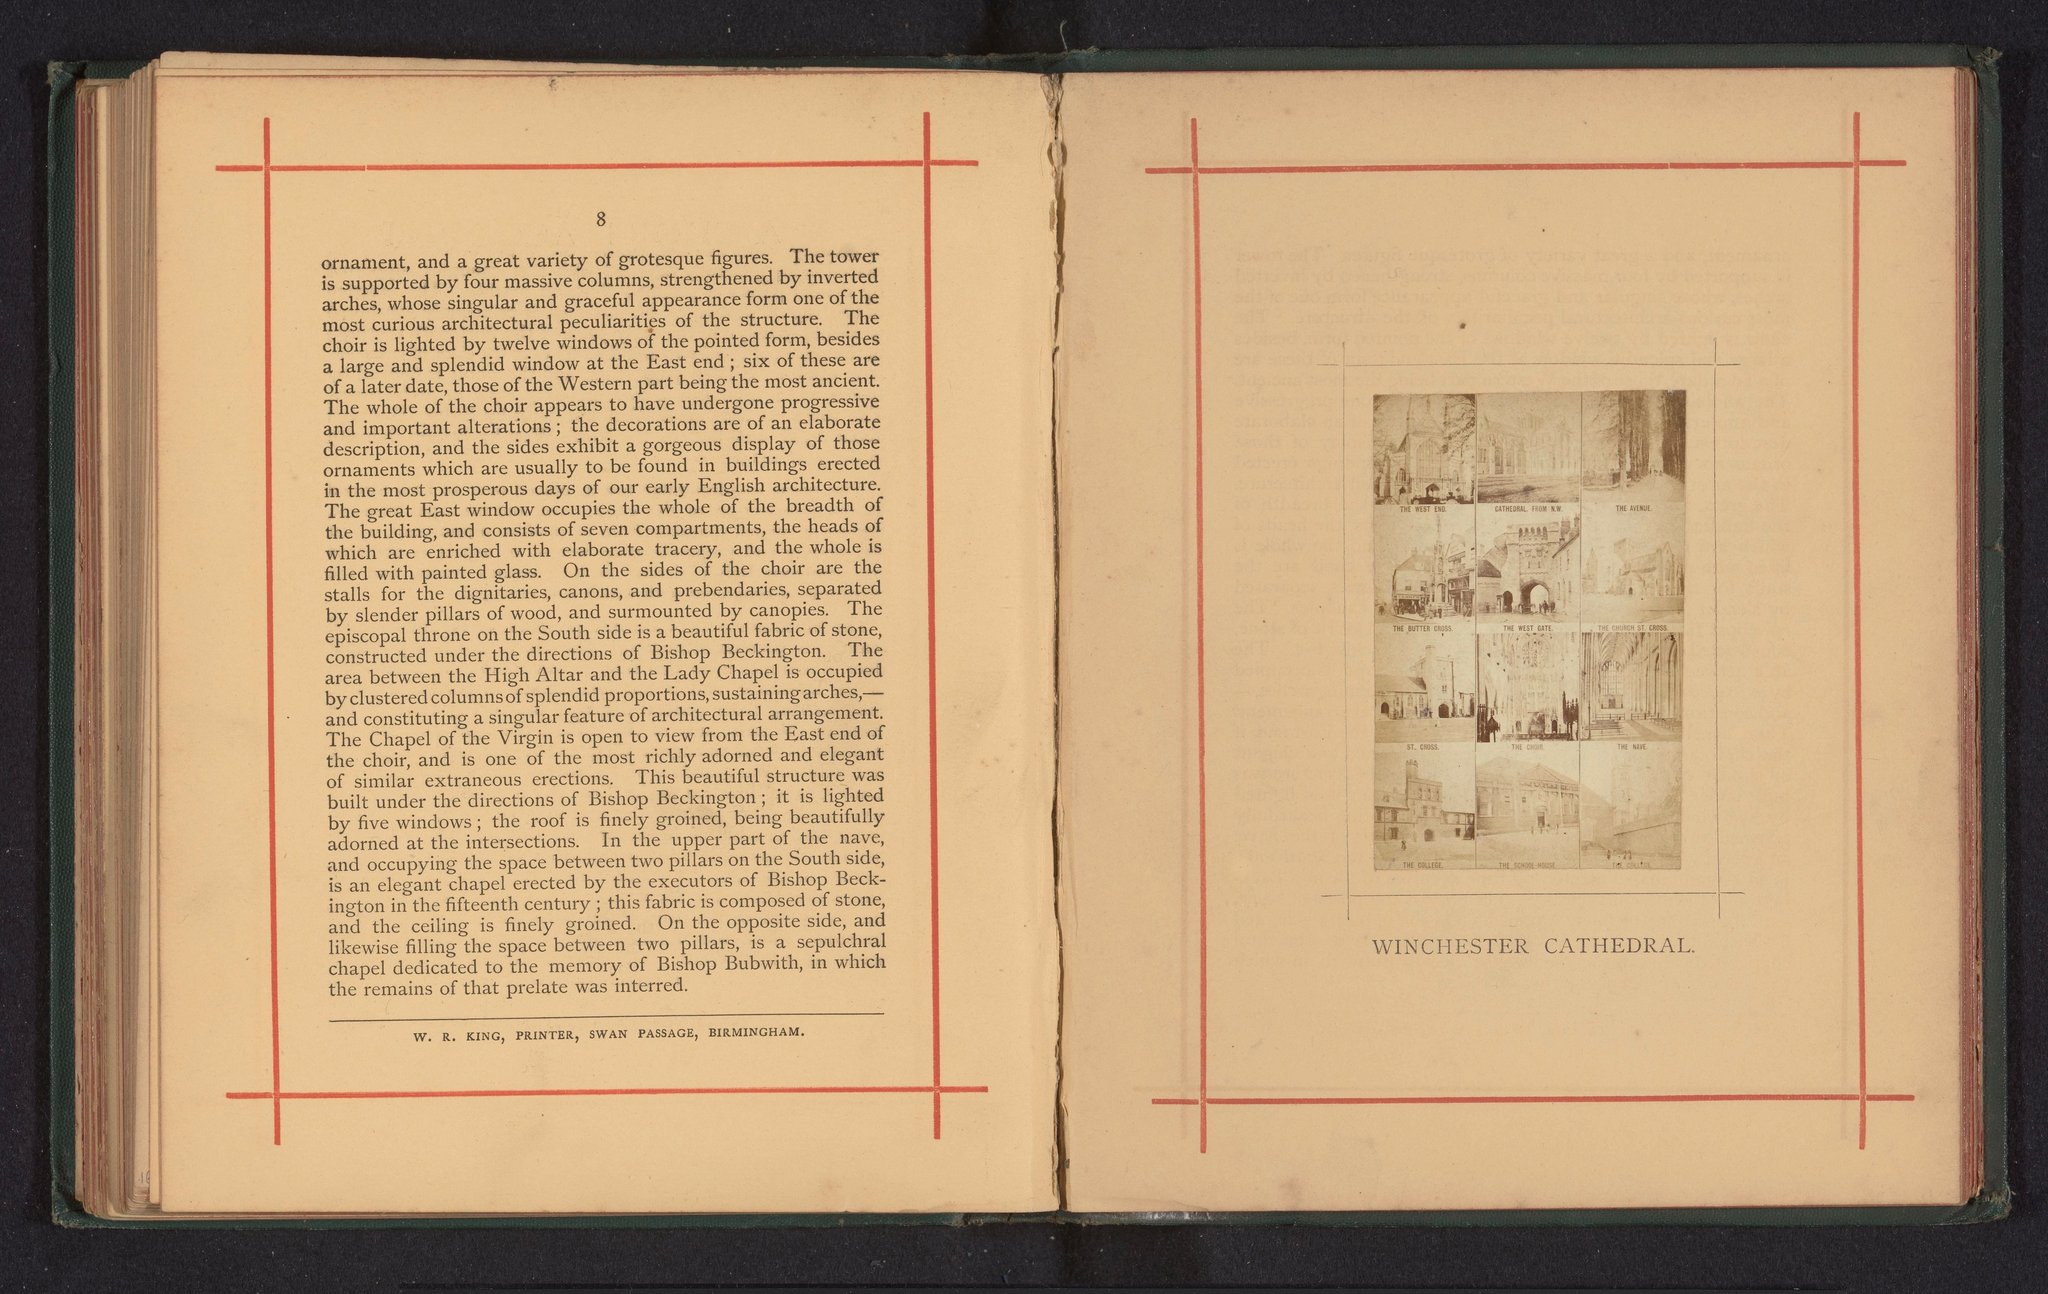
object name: photograph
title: Fotoreproductie van twaalf foto's van de kathedraal van Winchester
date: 1870-1880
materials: photographic support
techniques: albumen print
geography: winchester cathedral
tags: church (exterior), parts of church interior: nave, university building, college, parts of church interior: choir, winchester cathedral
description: Van boven naar beneden en van links naar rechts: tweemaal een gezicht op de kathedraal, de toegangsweg, een monument, een poort, tweemaal Saint Cross Church, het koor, het schip en driemaal een gezicht op een school.